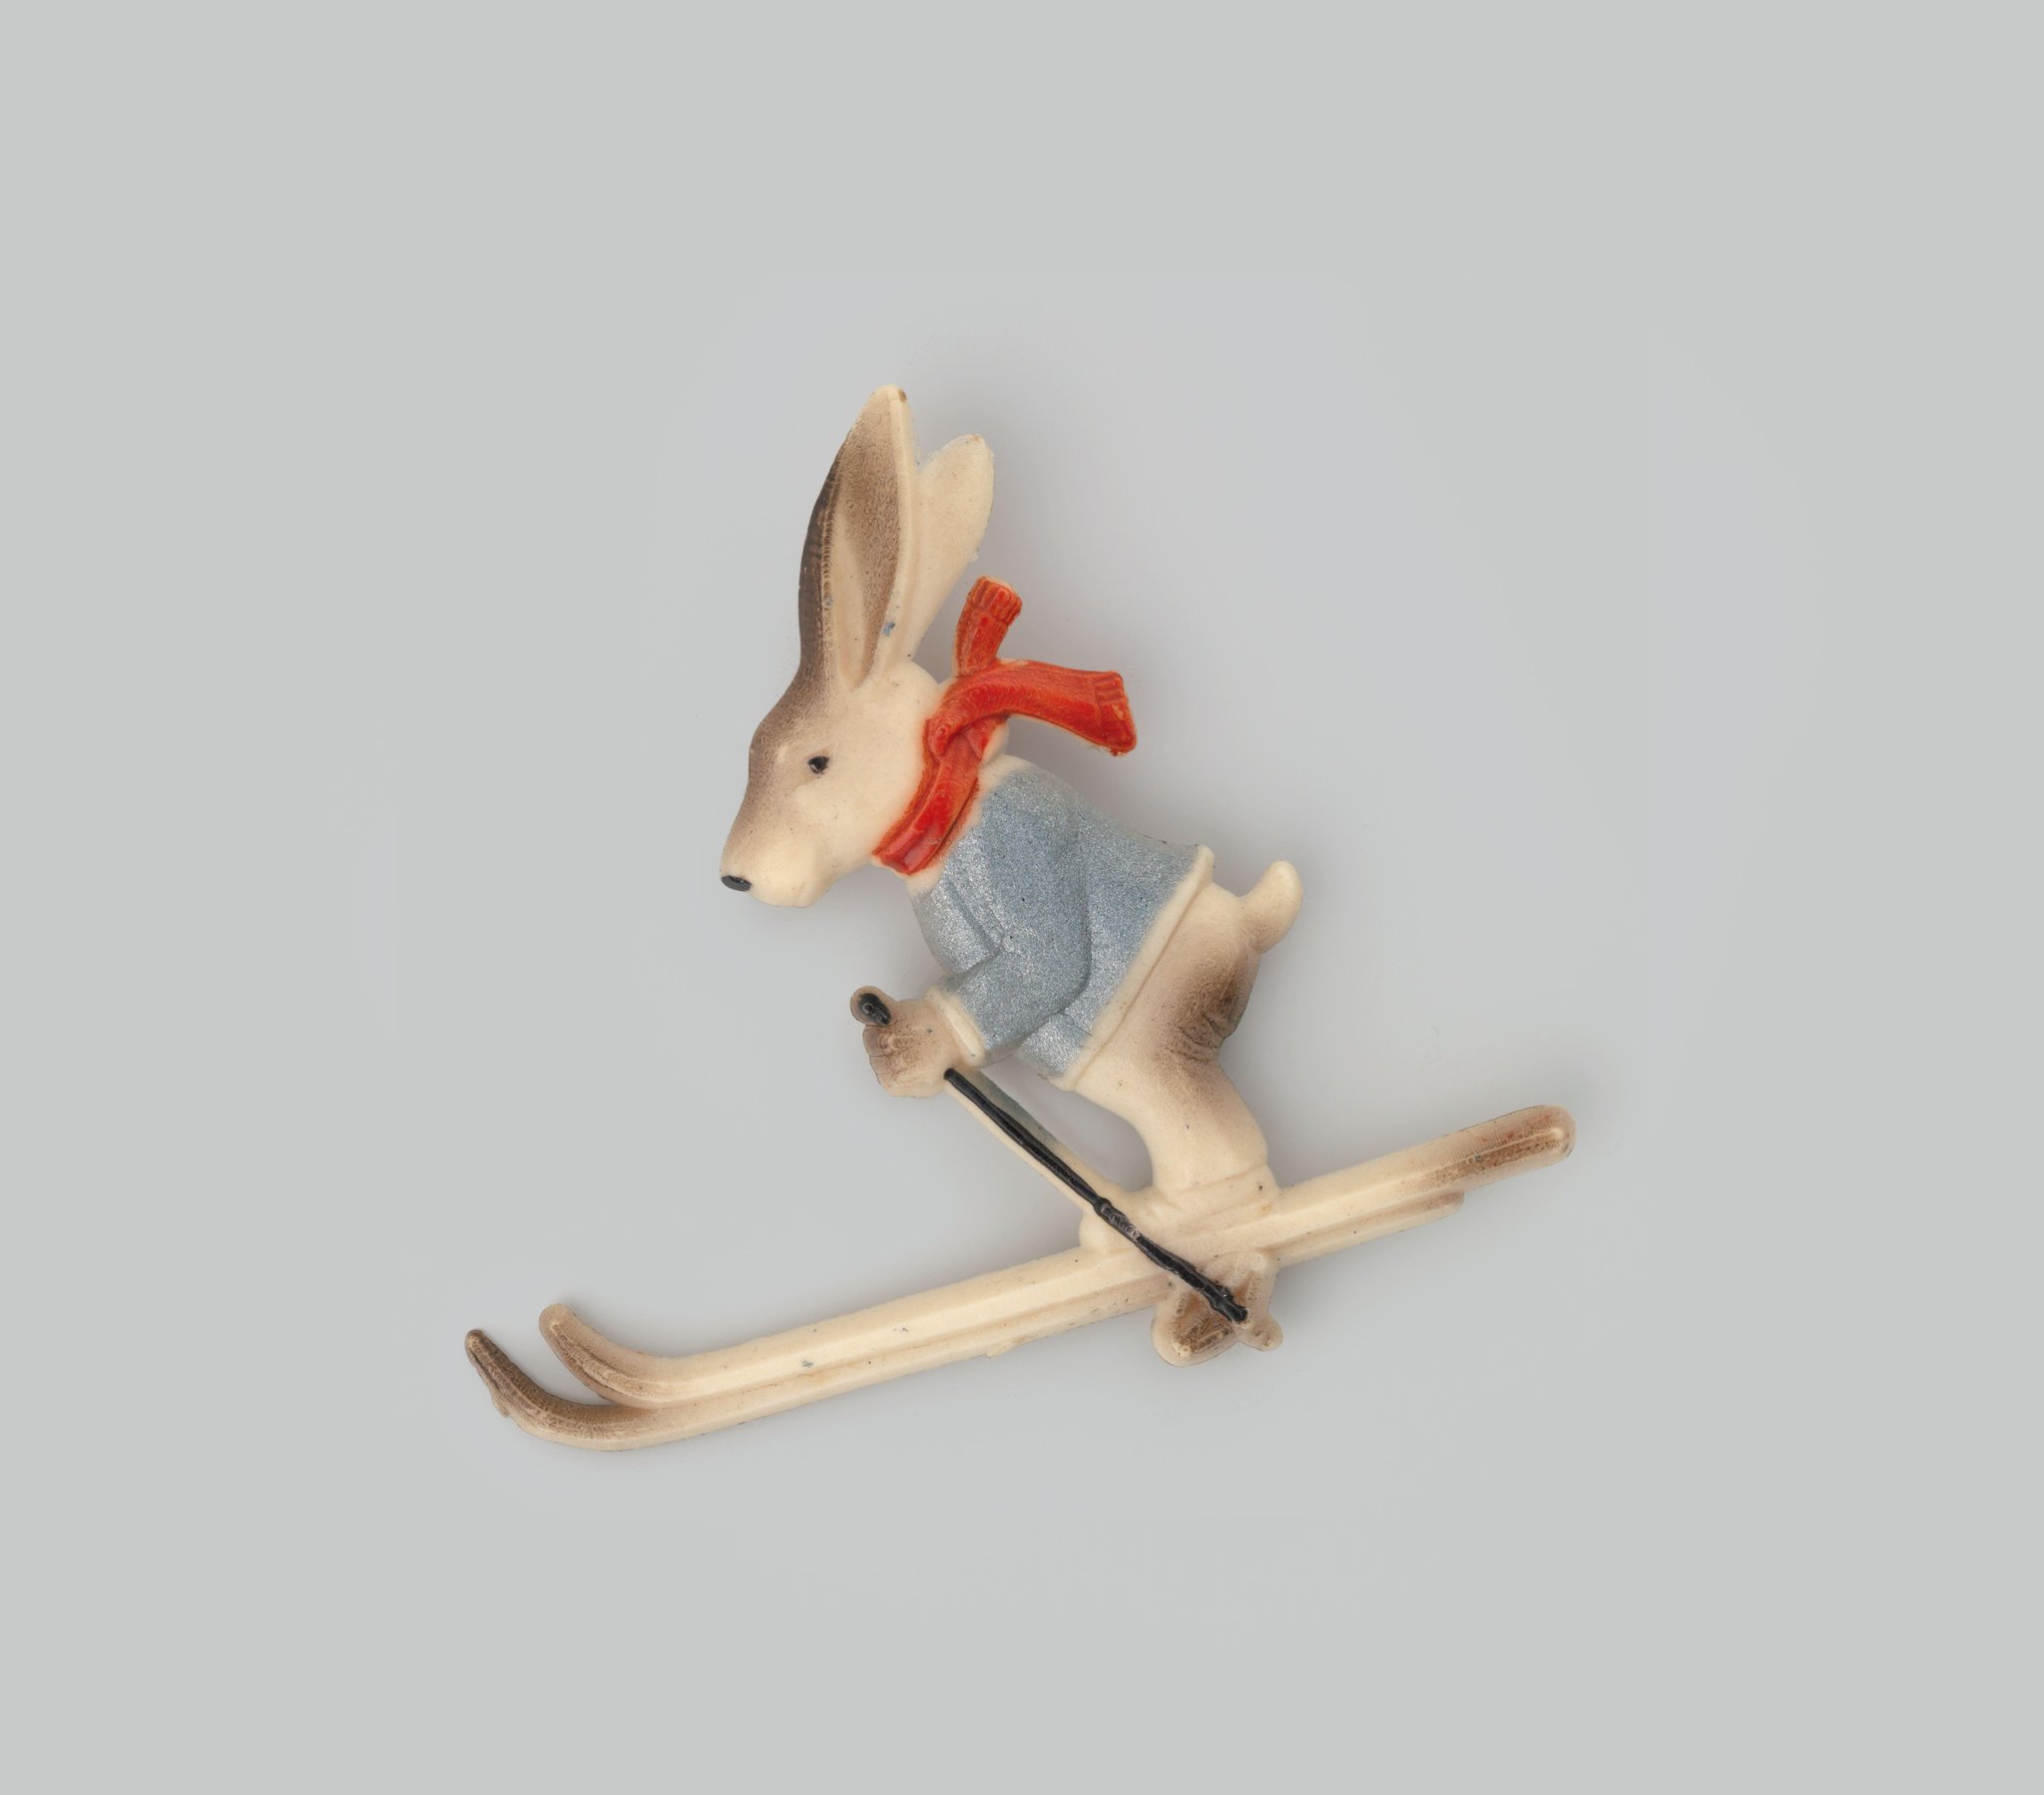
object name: brooch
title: Broche met skiënd konijn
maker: Anonymous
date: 1950-1960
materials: metal, plastic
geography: netherlands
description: Broche van kunststof met brochering van metaal. Konijn in blauw jasje met rood sjaaltje.